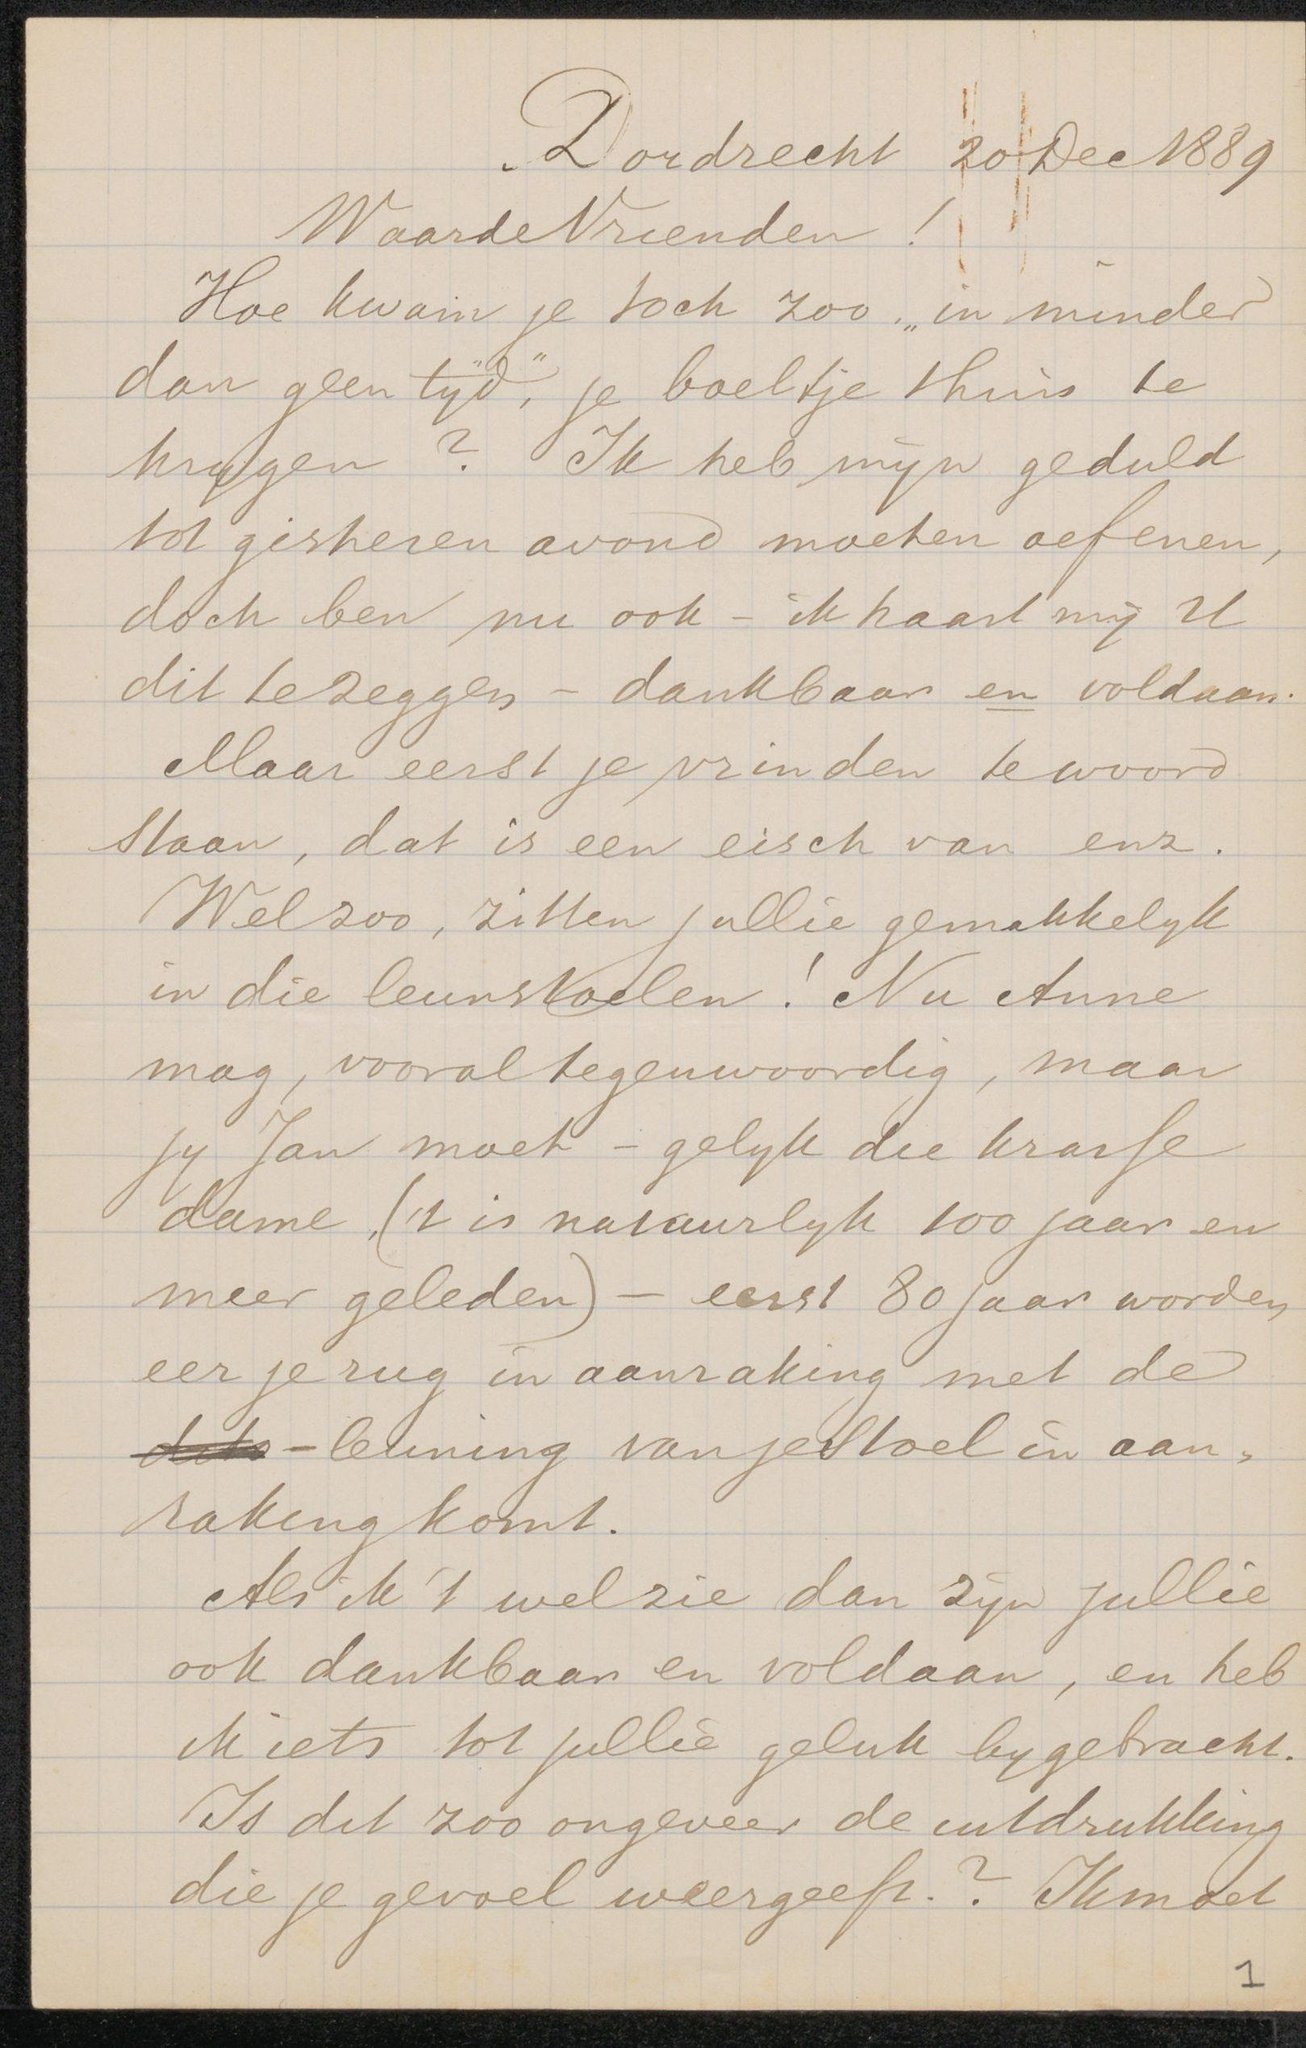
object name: letter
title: Brief aan Jan Veth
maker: martinus cornelis lebret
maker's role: verzamelaar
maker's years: 1833-1894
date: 1889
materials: ink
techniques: pen, writing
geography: dordrecht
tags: dordrecht, amsterdam, painter, print maker, draughtsman, designer, jan veth, portrait, self-portrait of artist, money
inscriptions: collector's mark: ‘RPK’